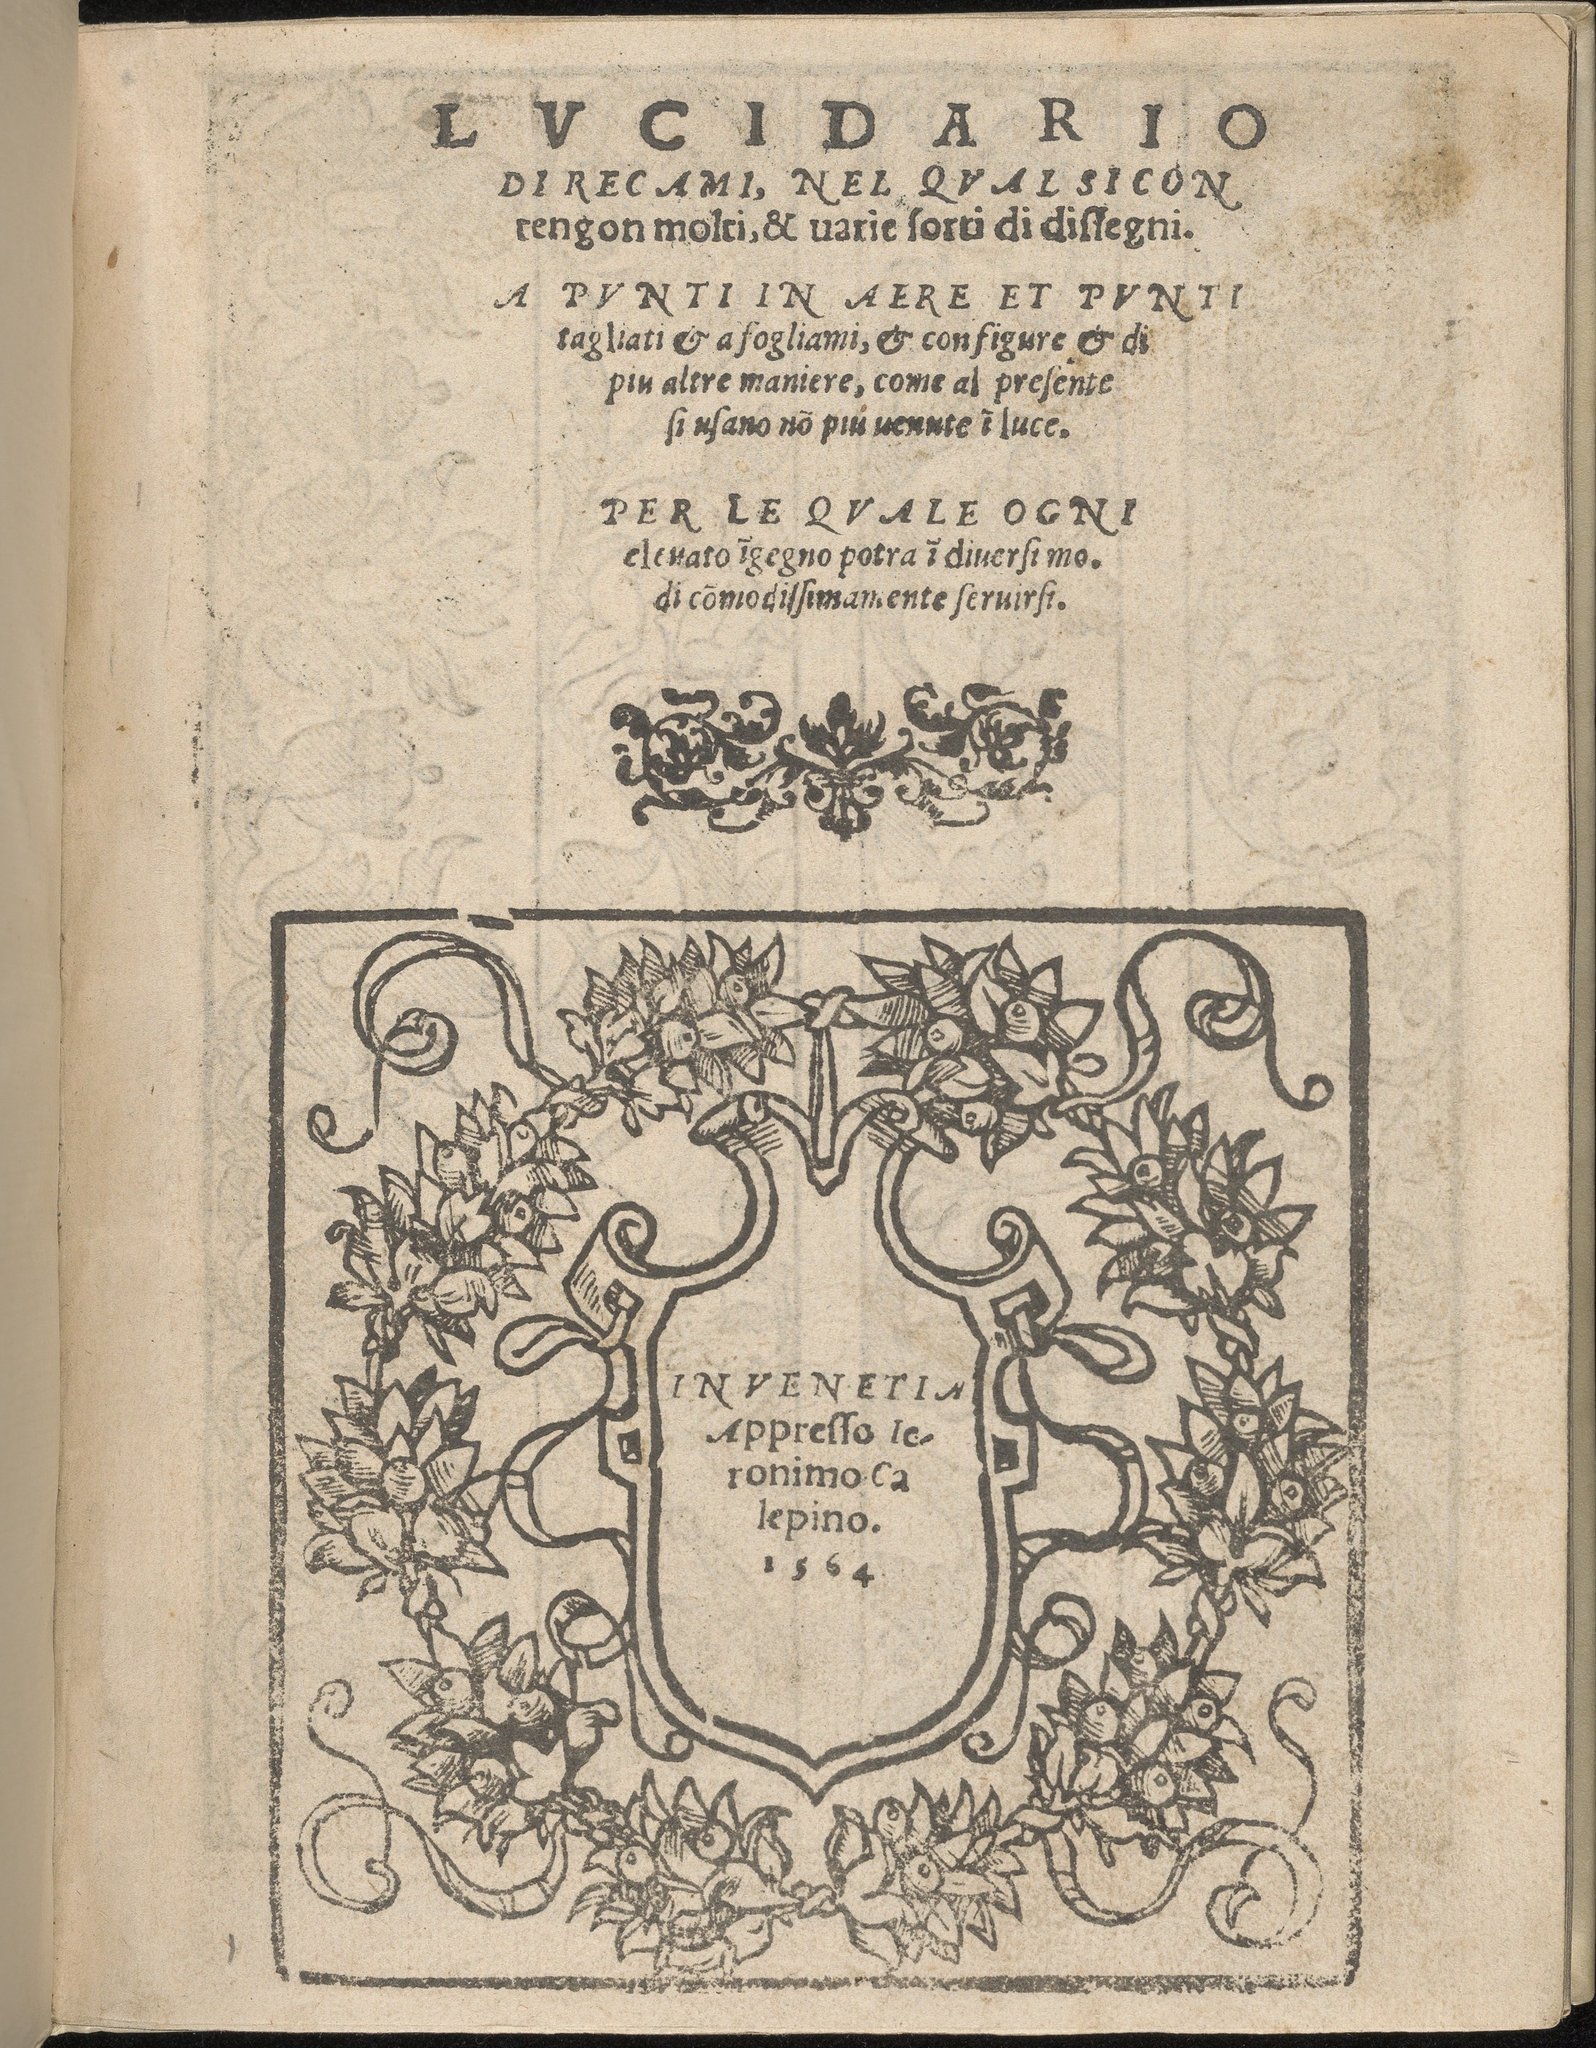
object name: book print ornament architecture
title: Lucidario di Recami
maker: iseppo foresto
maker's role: designer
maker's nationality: italian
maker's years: 1520-1580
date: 1564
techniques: woodcut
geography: italy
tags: cartouches